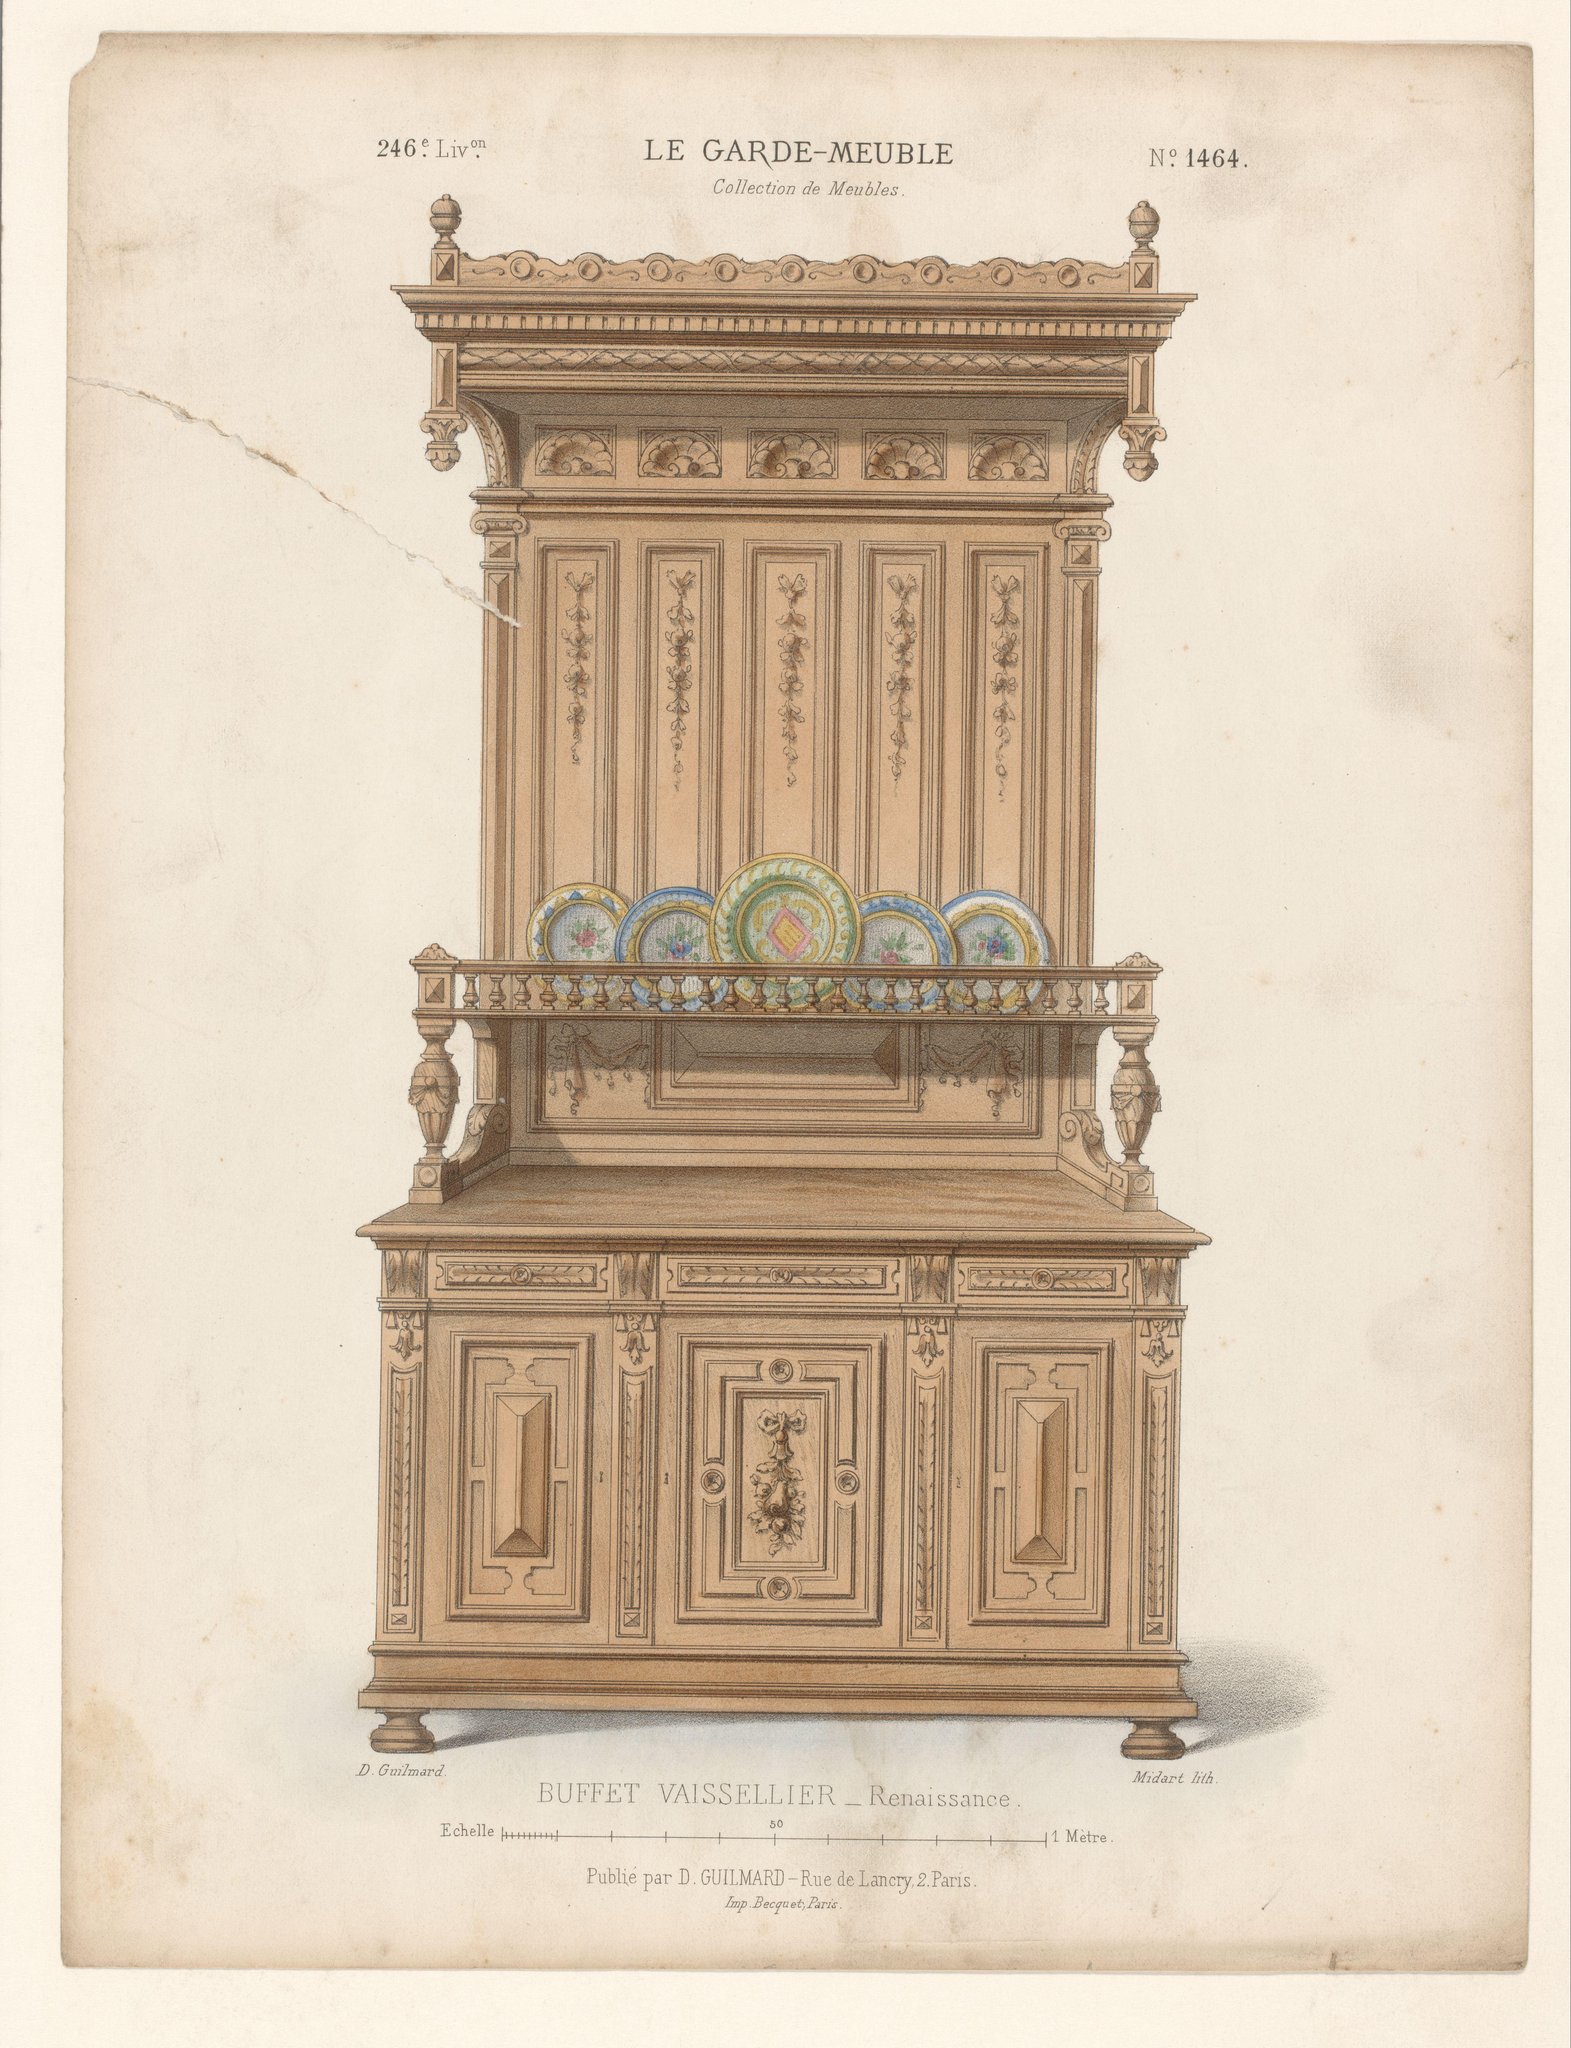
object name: print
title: Buffetkast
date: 1839-1885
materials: paper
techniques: hand coloring, lithograph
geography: paris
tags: furniture for storage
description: Ieder Livraison in de serie Le Garde-Meuble bevat negen platen: drie 'sièges' (zitmeubels), drie 'meubles' (diverse meubels zoals tafels en kasten) en drie 'tentures' (gordijnen en draperieën).